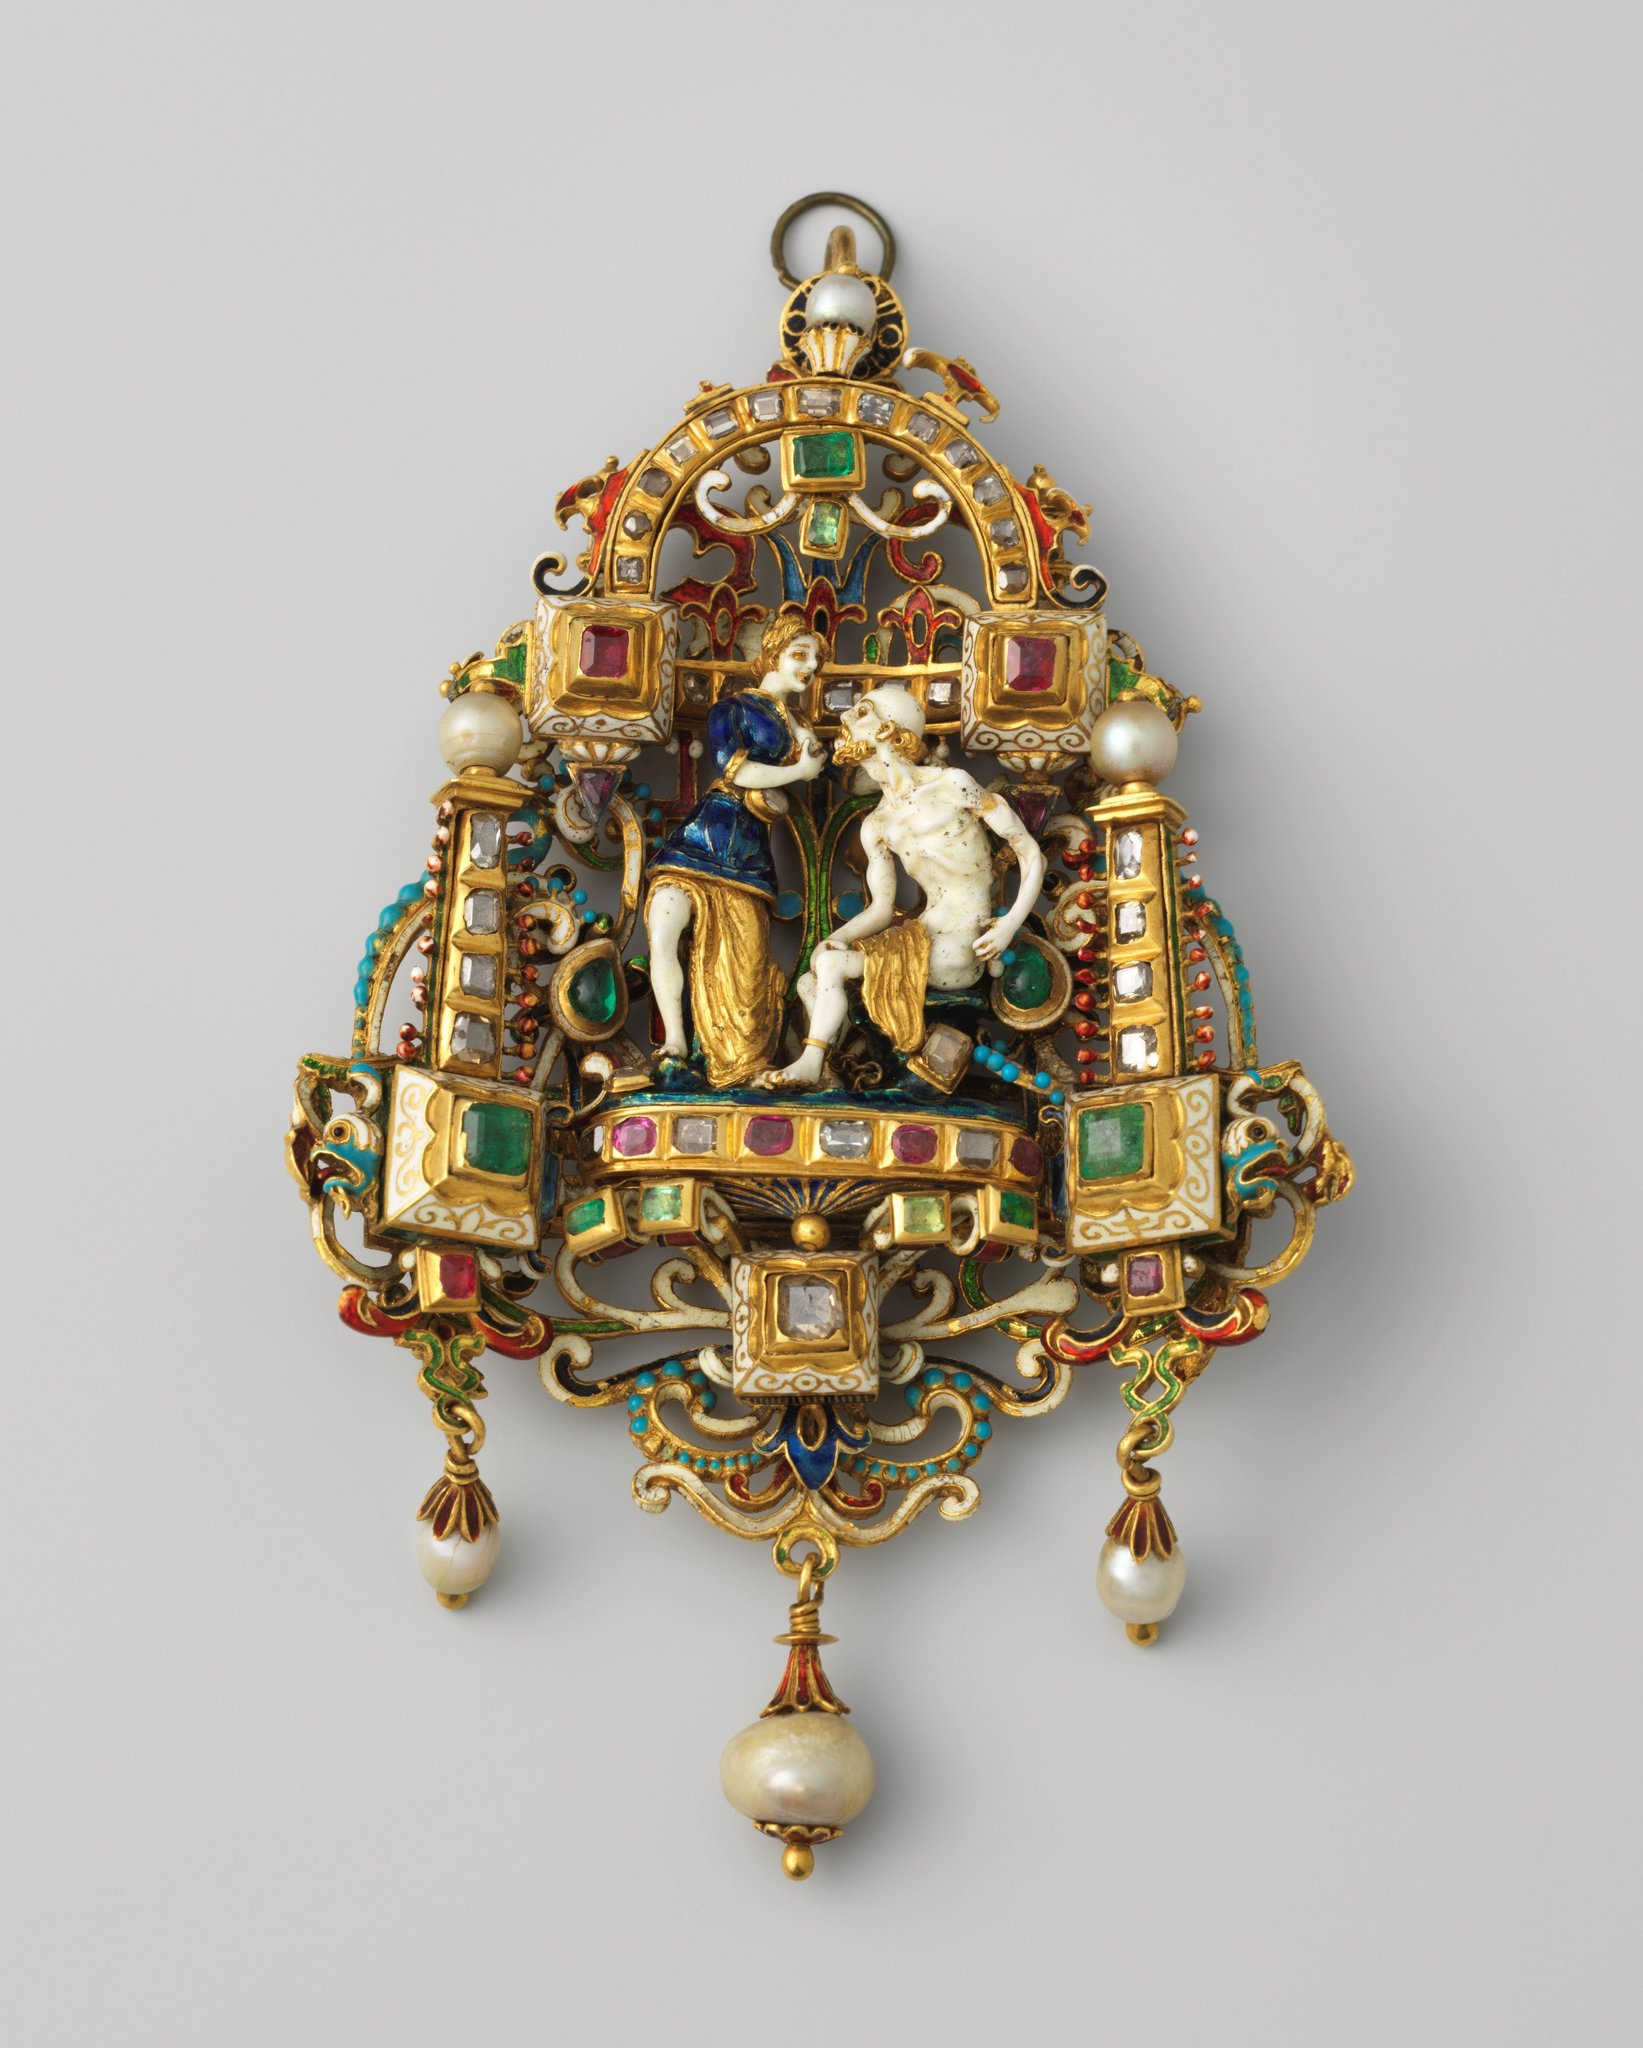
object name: pendant jewelry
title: Hanger van goud, email, parels en edelstenen. In het midden Cimon en Pero, geheel geëmailleerd.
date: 1585-1600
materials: gold, pearl, gemstone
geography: southern germany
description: Hanger van goud, email, parels en edelstenen. In het midden Cimon en Pero, geheel geëmailleerd.